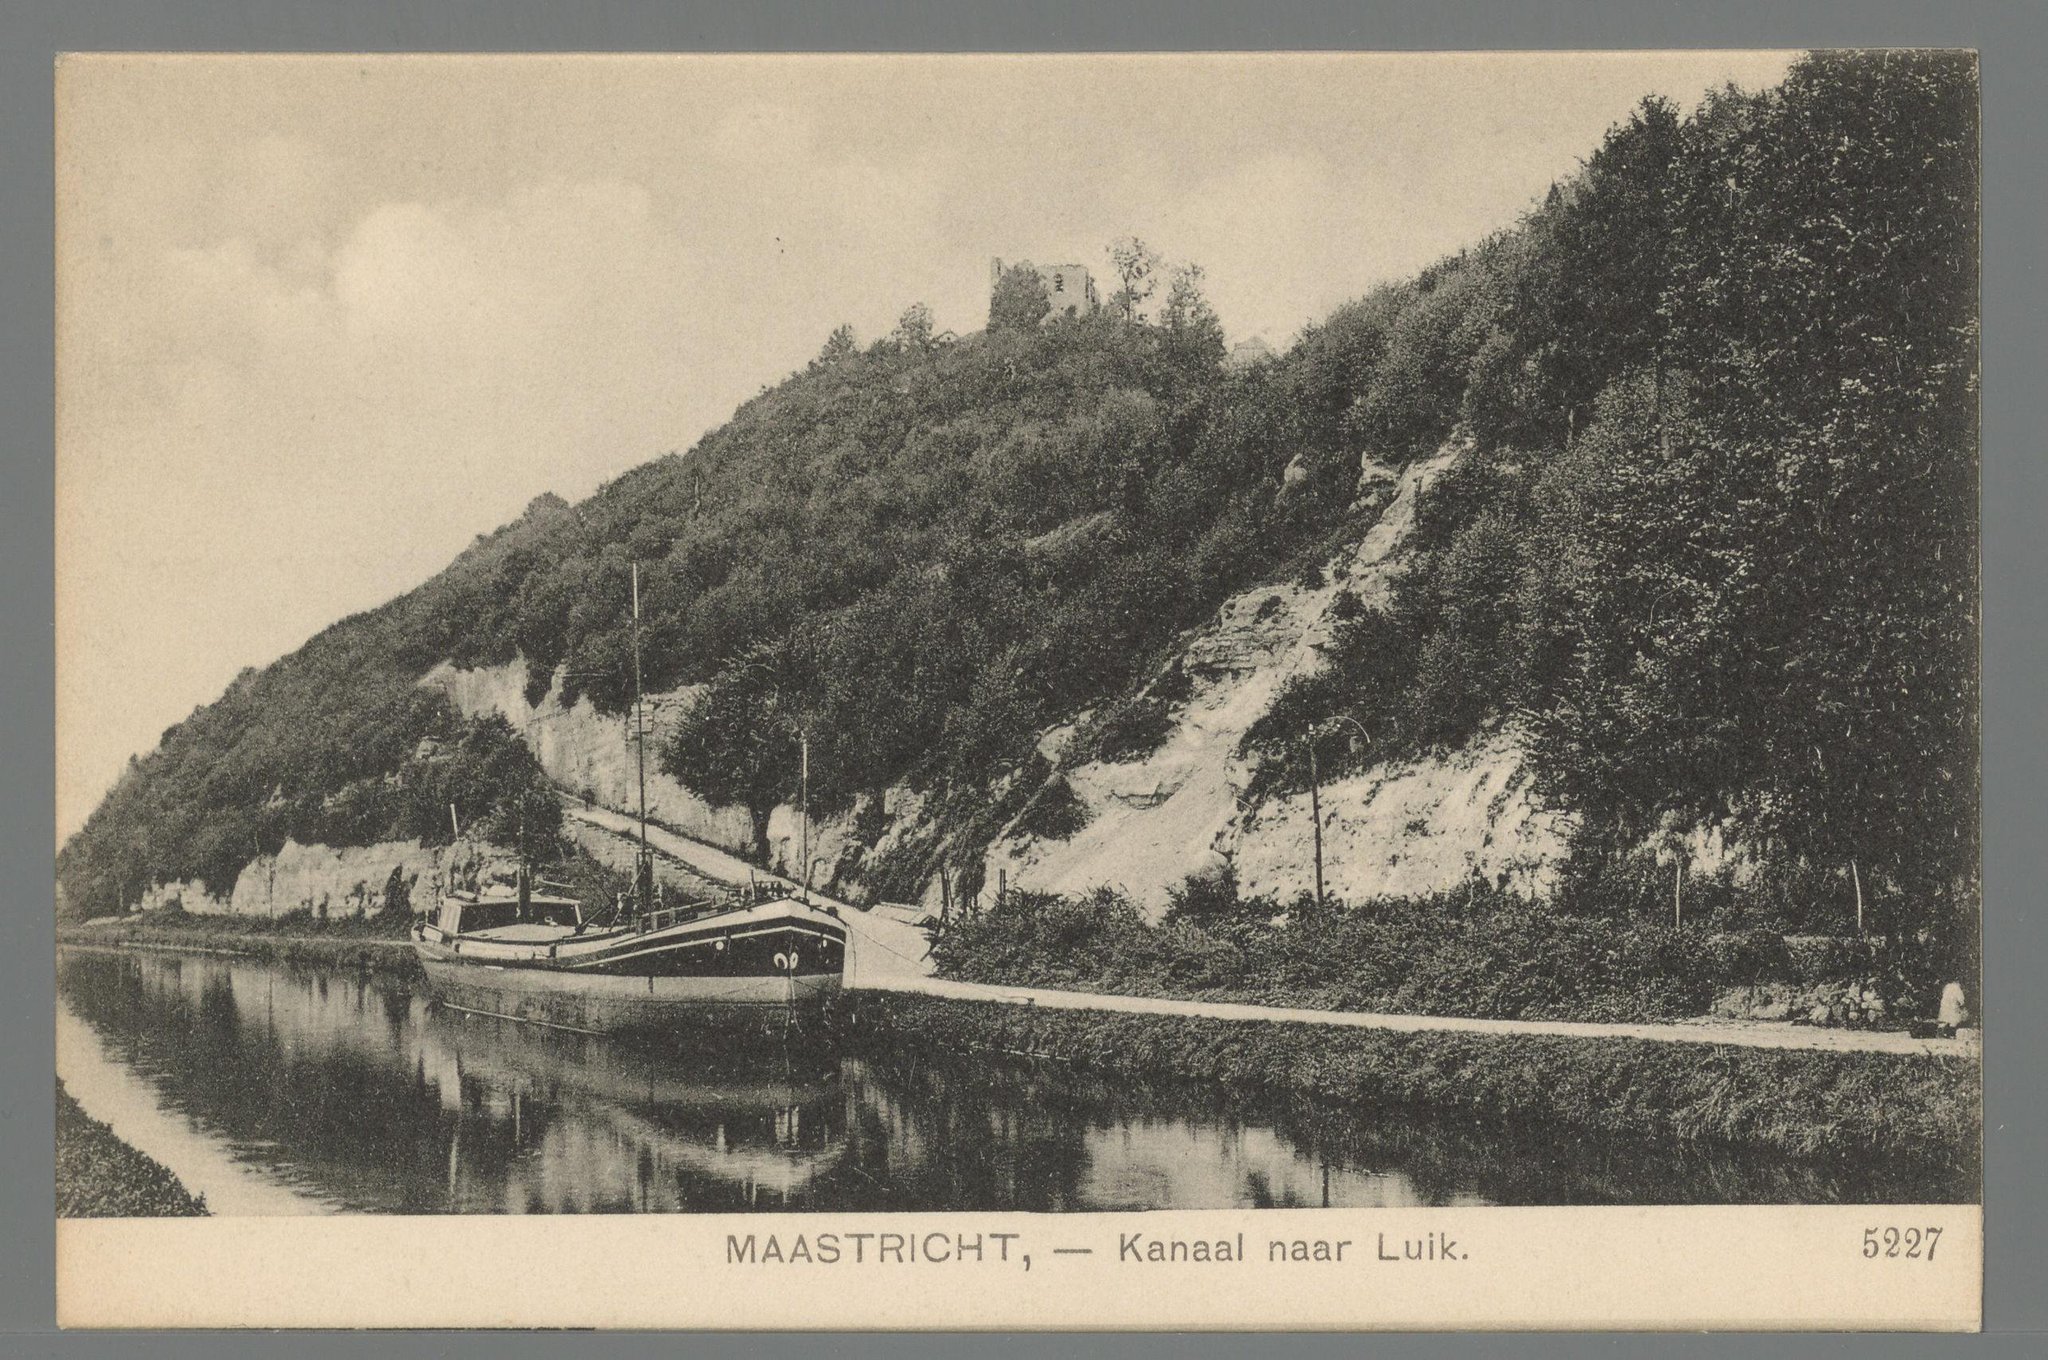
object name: photomechanical print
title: Maastricht, - Kanaal naar Luik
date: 1905-1927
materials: cardboard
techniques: photograph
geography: velsen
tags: sailing-ship, sailing-boat, canal, maastricht